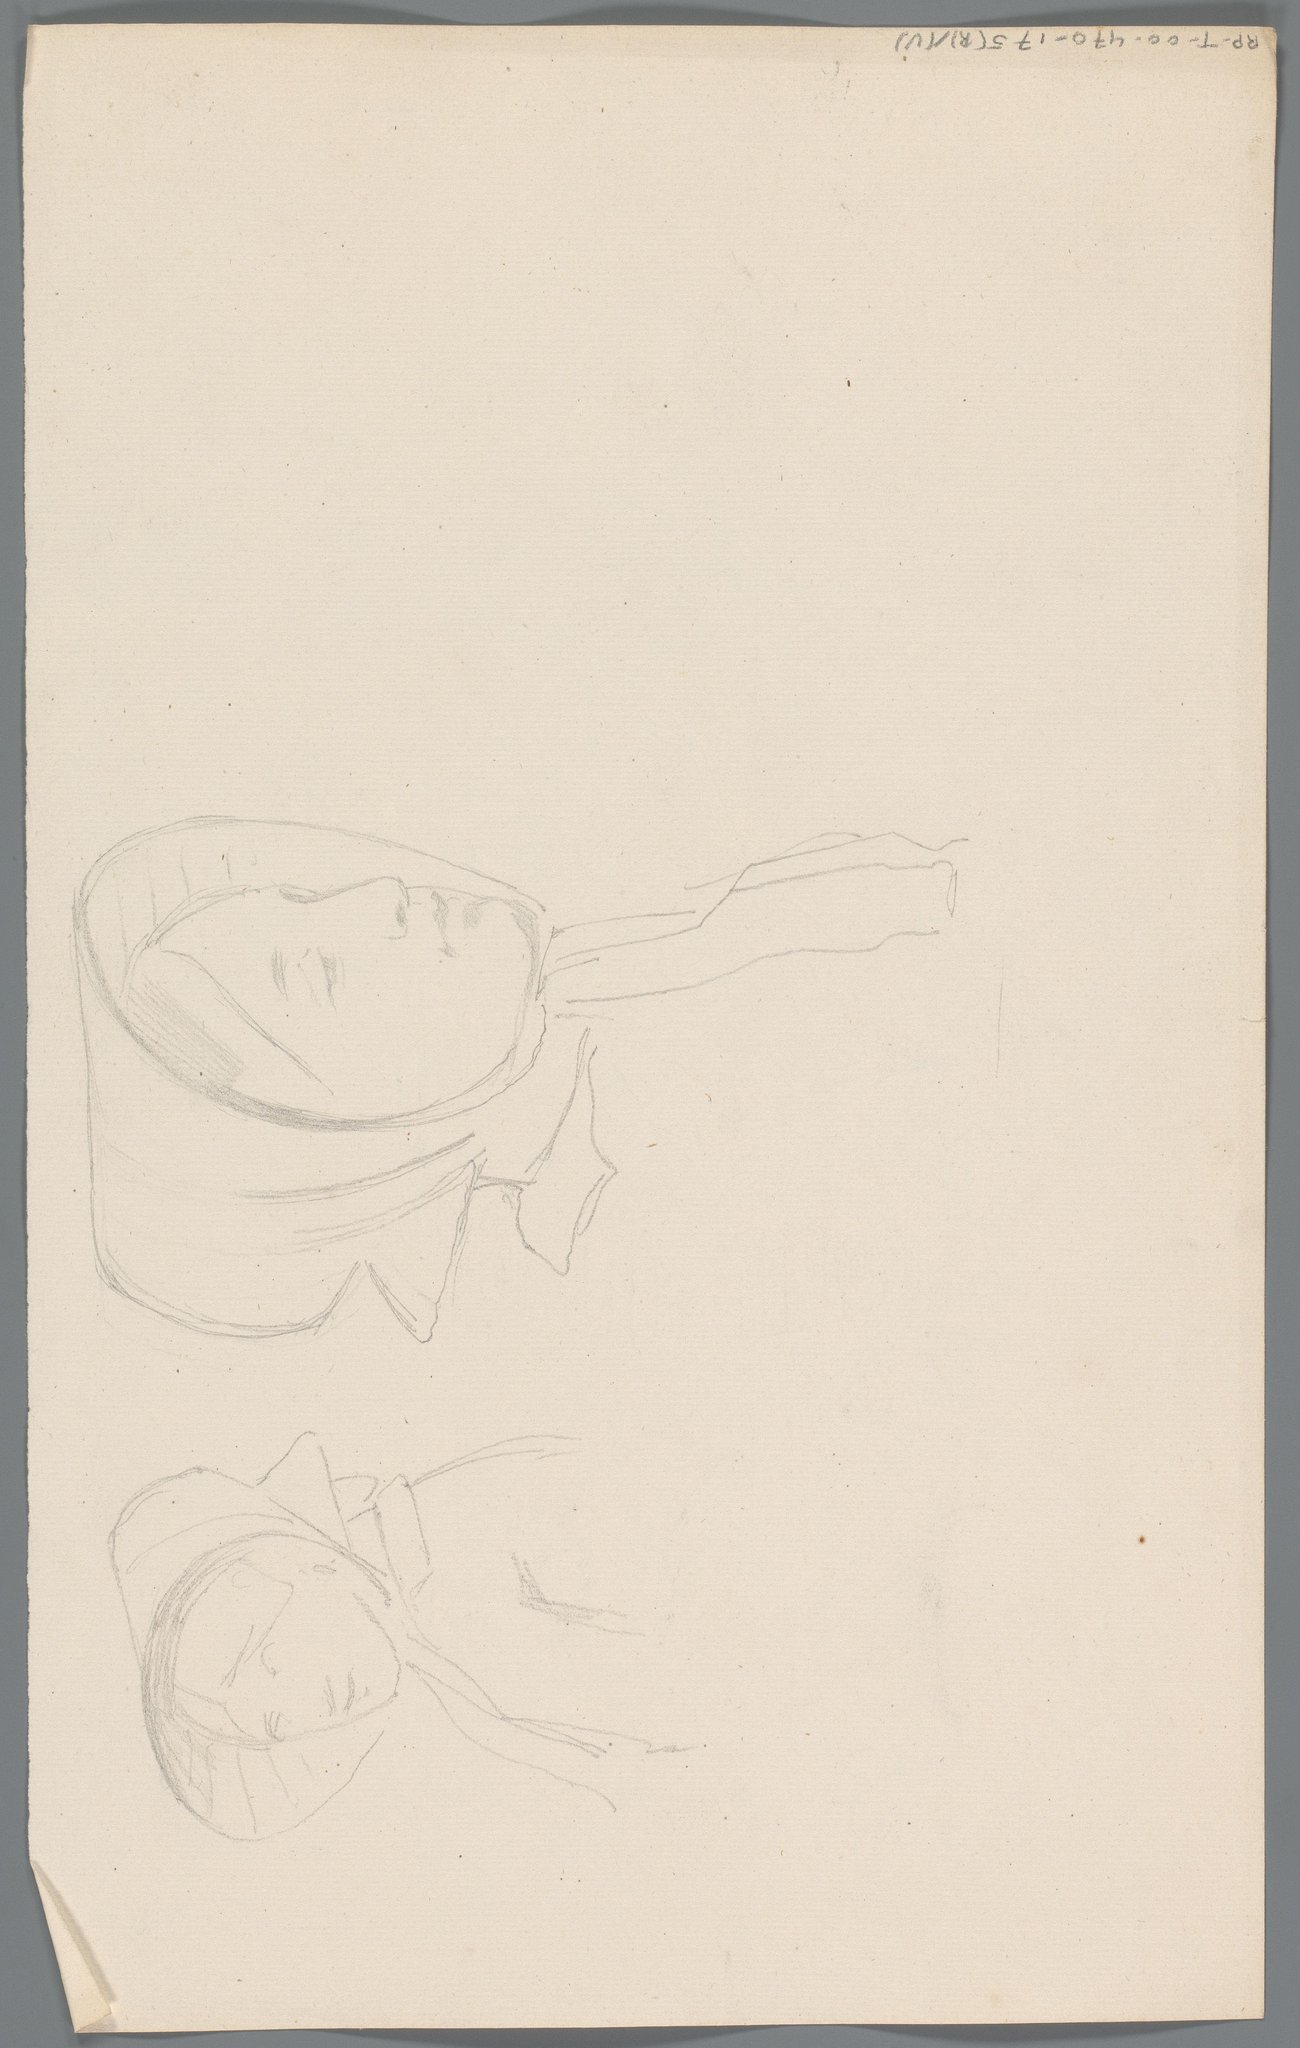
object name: drawing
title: Studie van een vrouwengezicht met kap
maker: jacobus everhardus josephus van den berg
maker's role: draughtsman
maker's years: 1802-1861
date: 1812-1861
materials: paper, pencil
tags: face, head-gear